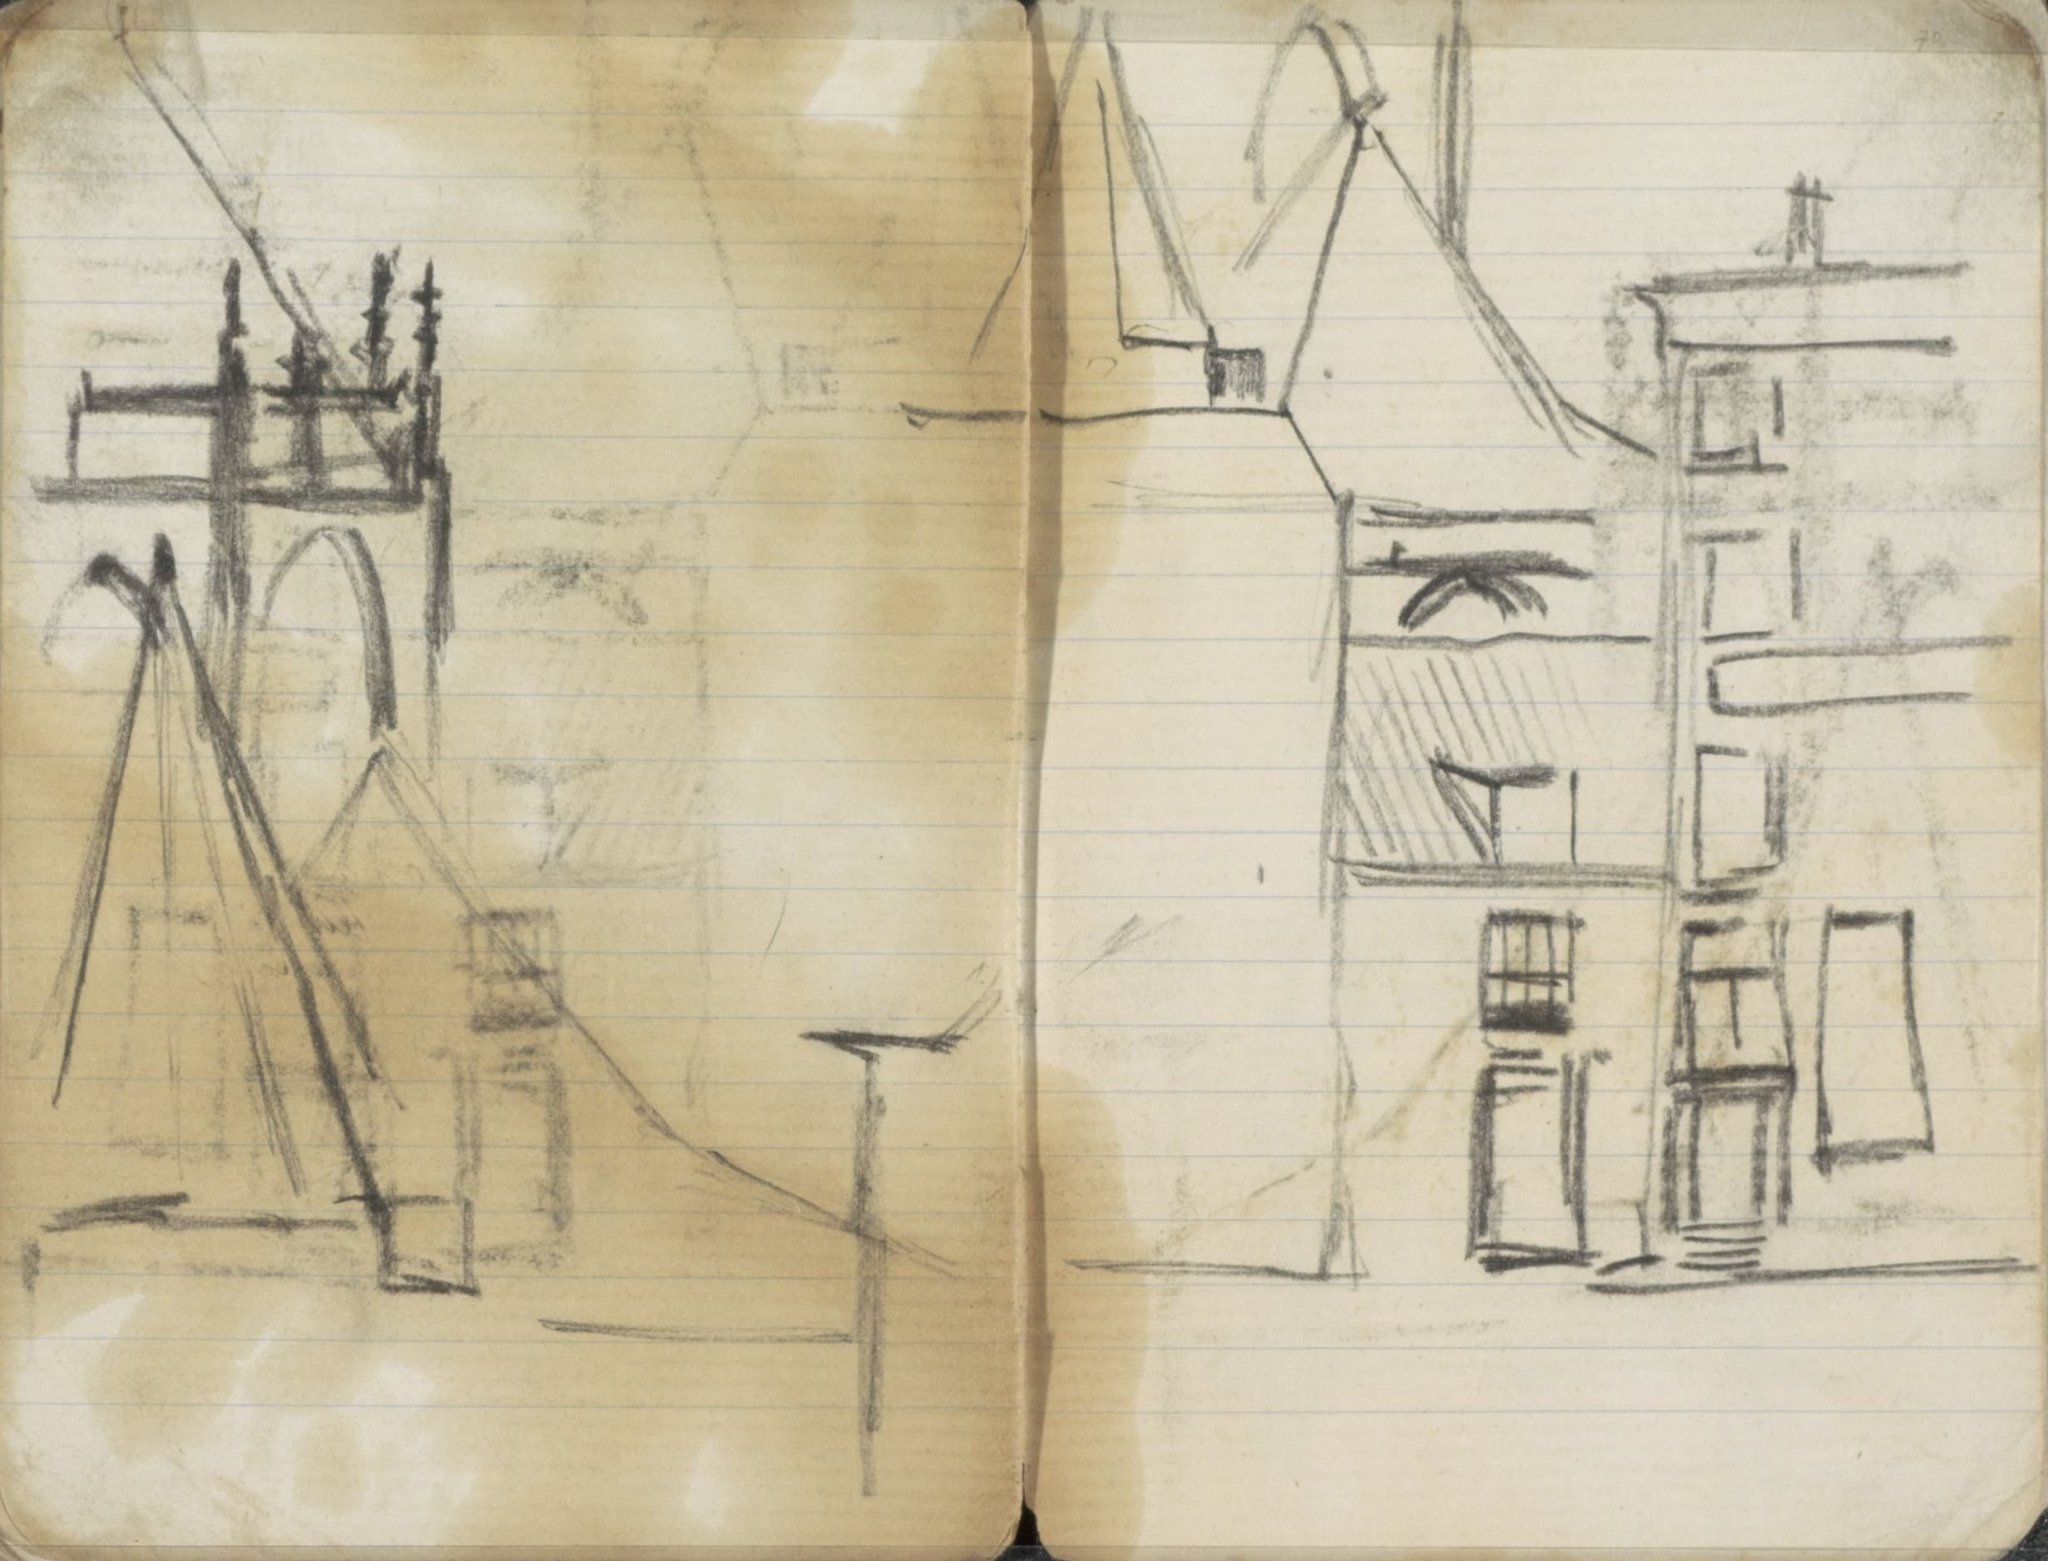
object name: sketchbook leaf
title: Gezicht op de Dam in Amsterdam met de Nieuwe Kerk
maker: george hendrik breitner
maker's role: draughtsman, painter, print maker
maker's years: 1857-1923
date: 1896-1901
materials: chalk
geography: amsterdam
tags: square, place, circus, etc., church (exterior), civic architecture; edifices; dwellings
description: Pagina 69 en pagina 70 uit een schetsboek met 37 bladen.